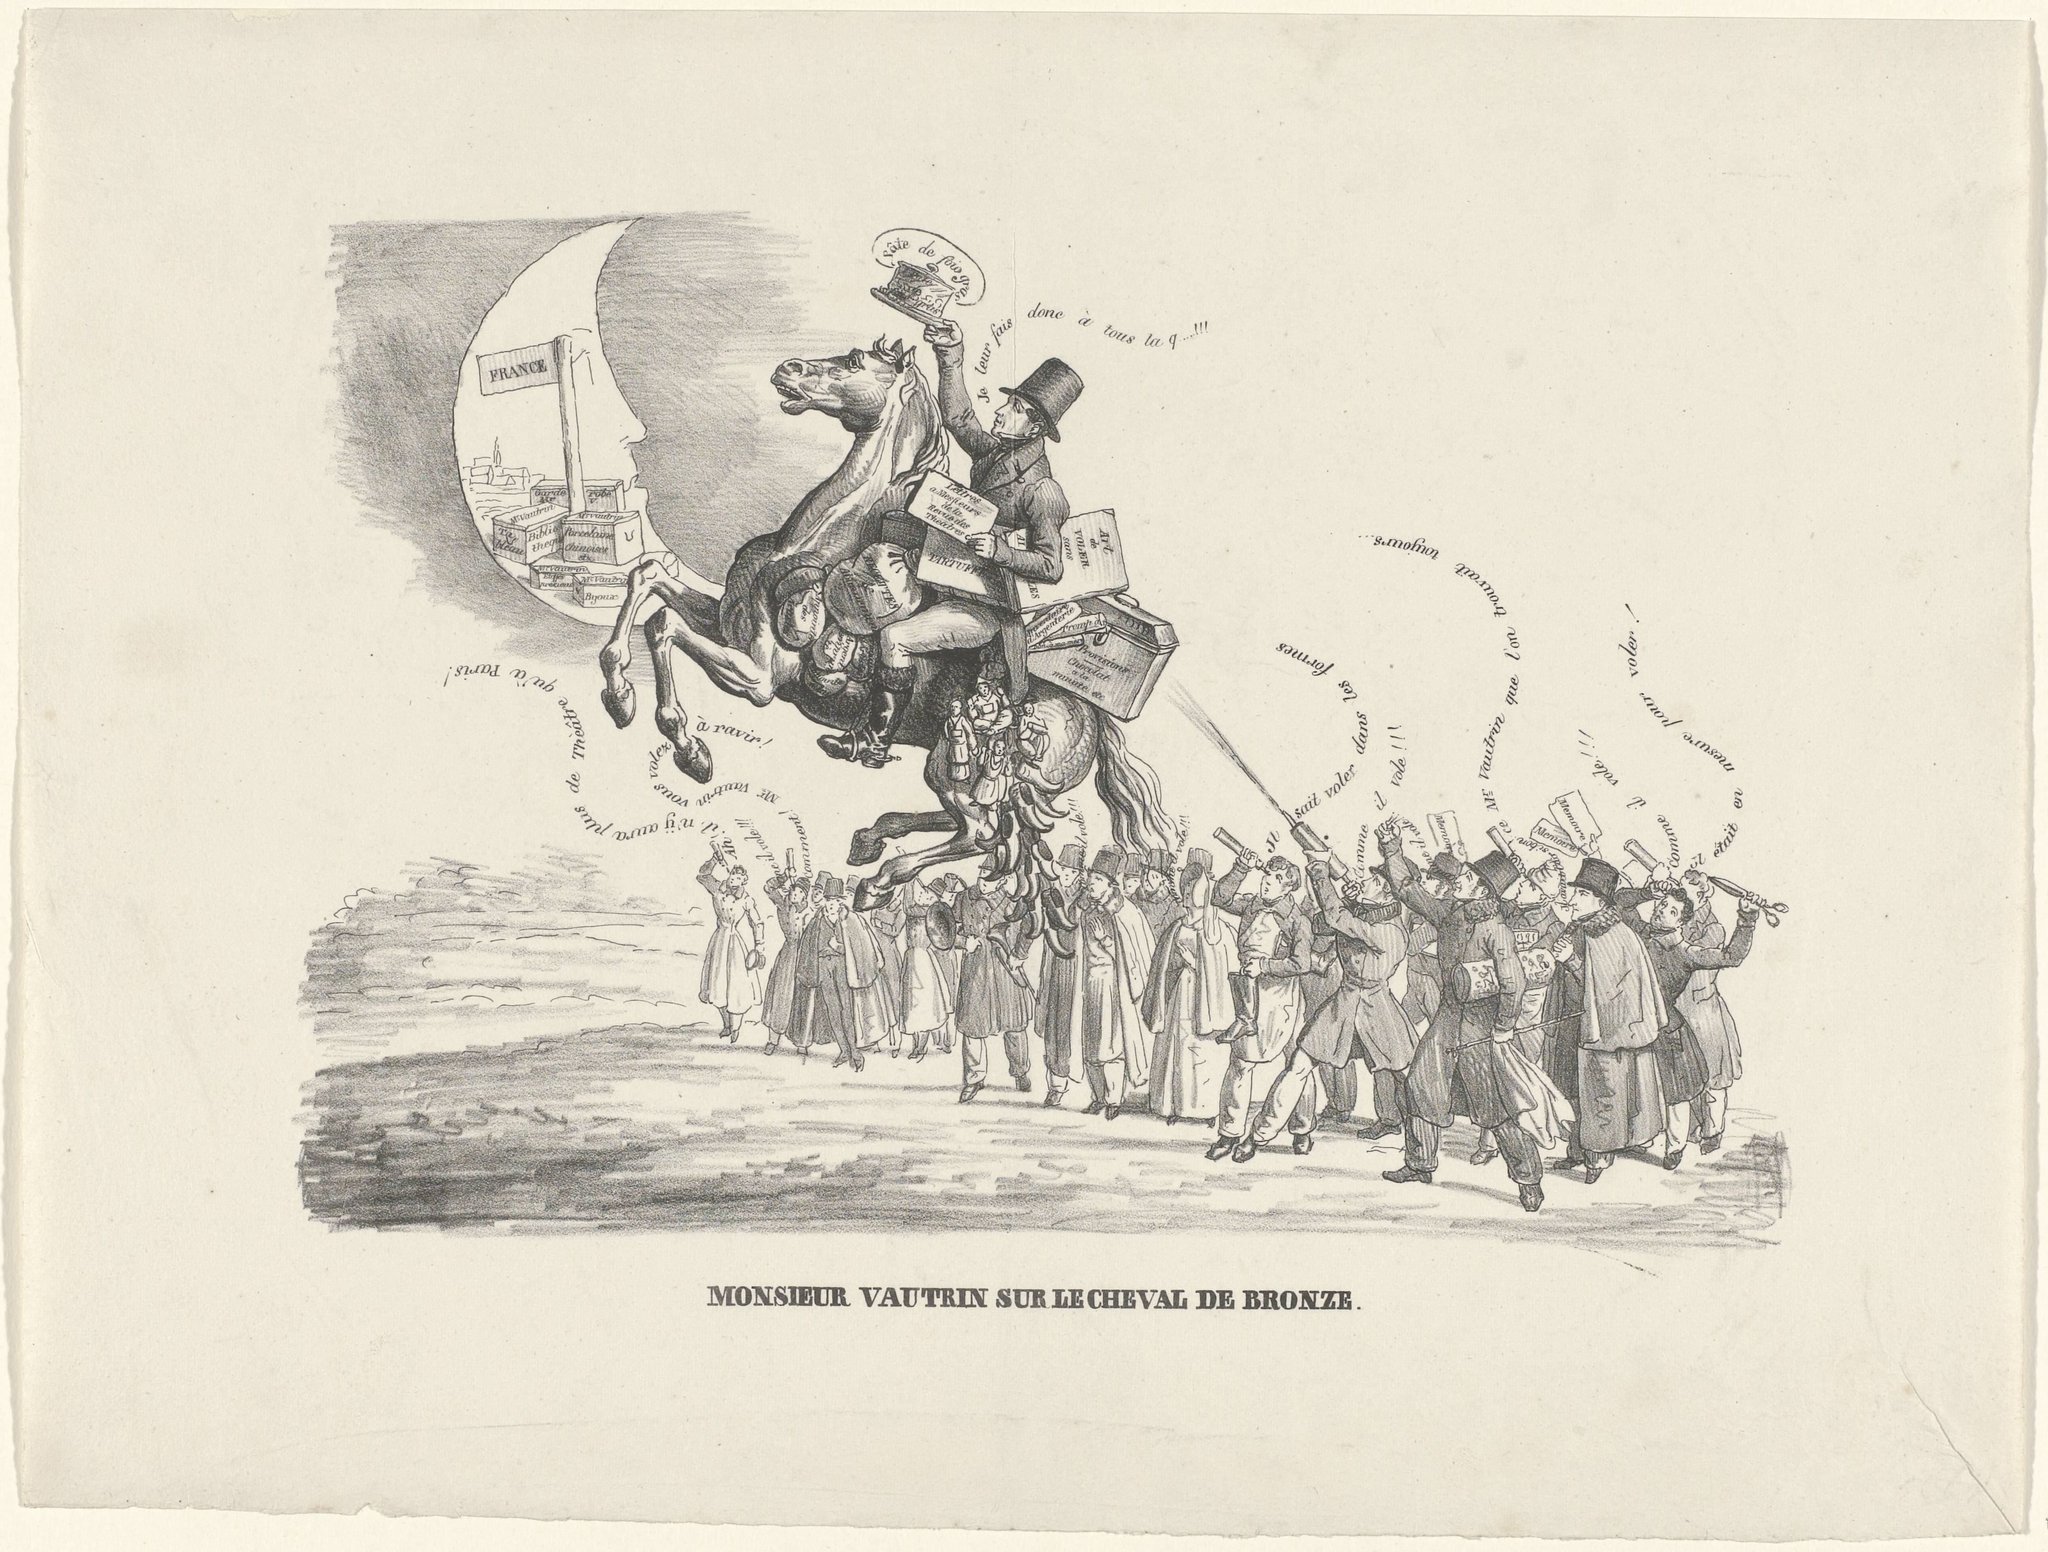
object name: print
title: Monsieur Vautrin sur le cheval de bronze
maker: Anonymous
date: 1838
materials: paper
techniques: lithograph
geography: netherlands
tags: opera, opera house, paris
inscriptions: collector's mark: Lugt 2228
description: Spotprent op het vertrek van Vautrin, de directeur van de Franse Opera in de Koninklijke Schouwburg te Den Haag, naar Parijs, 1838. Naar analogie van de opera van Auber genaamd 'Cheval de bronze' rijdt Vautrin gezeten op een paard naar de maan, op de grond nagestaard door schuldeisers, muzikanten en anderen.